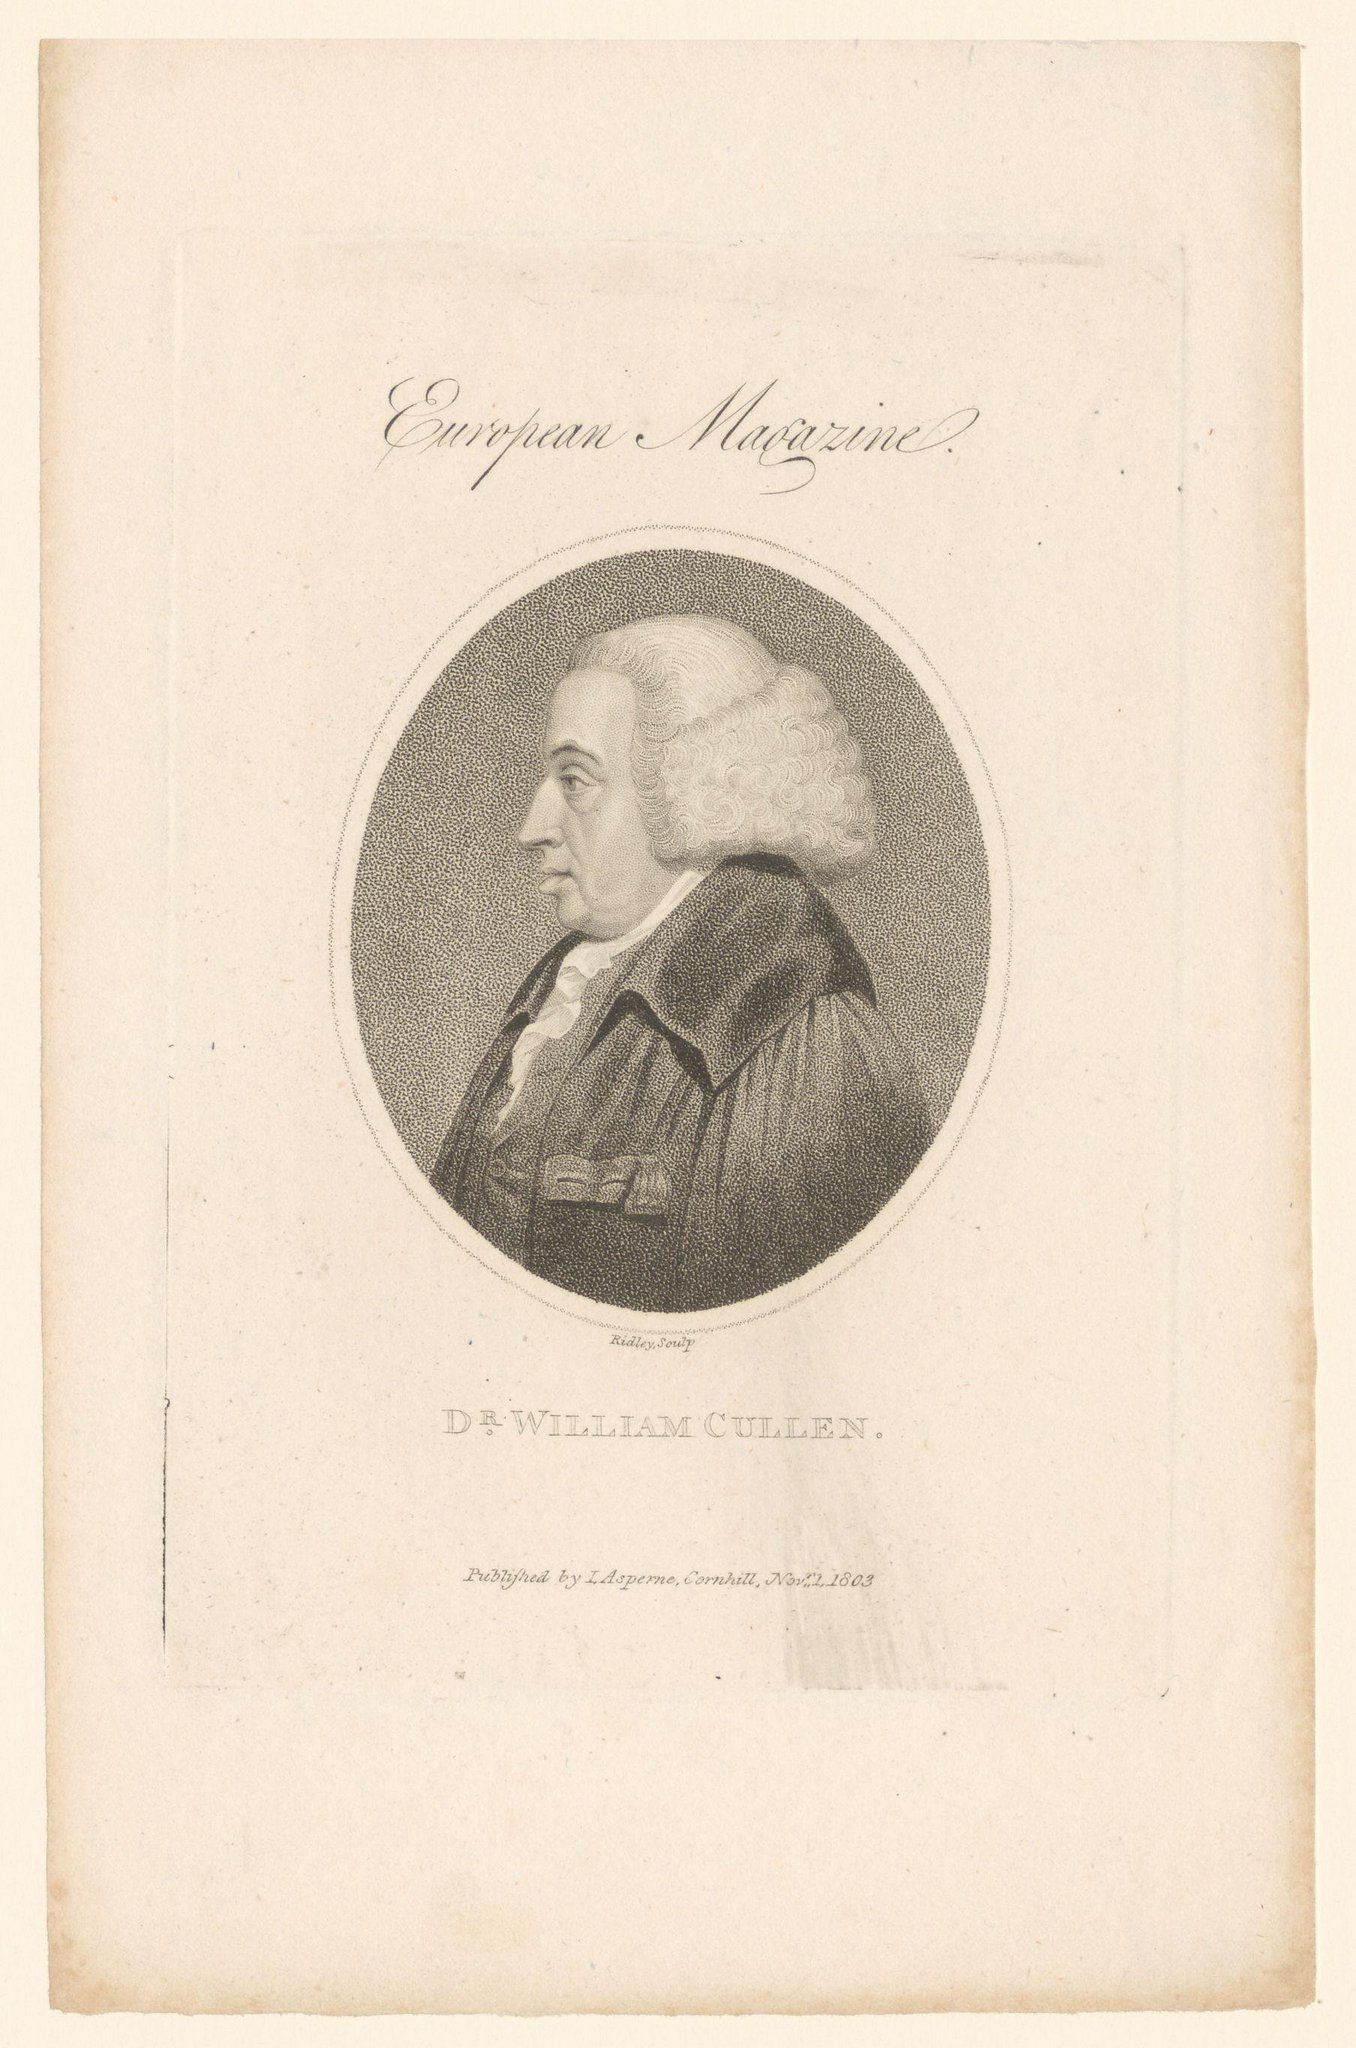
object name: print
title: Portret van William Cullen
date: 1803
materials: paper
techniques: stippling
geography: london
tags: historical persons, physician, doctor (+ portrait of scholar, scientist)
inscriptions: collector's mark: Lugt 2228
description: Prent gebruikt in: European Magazine, 1803.